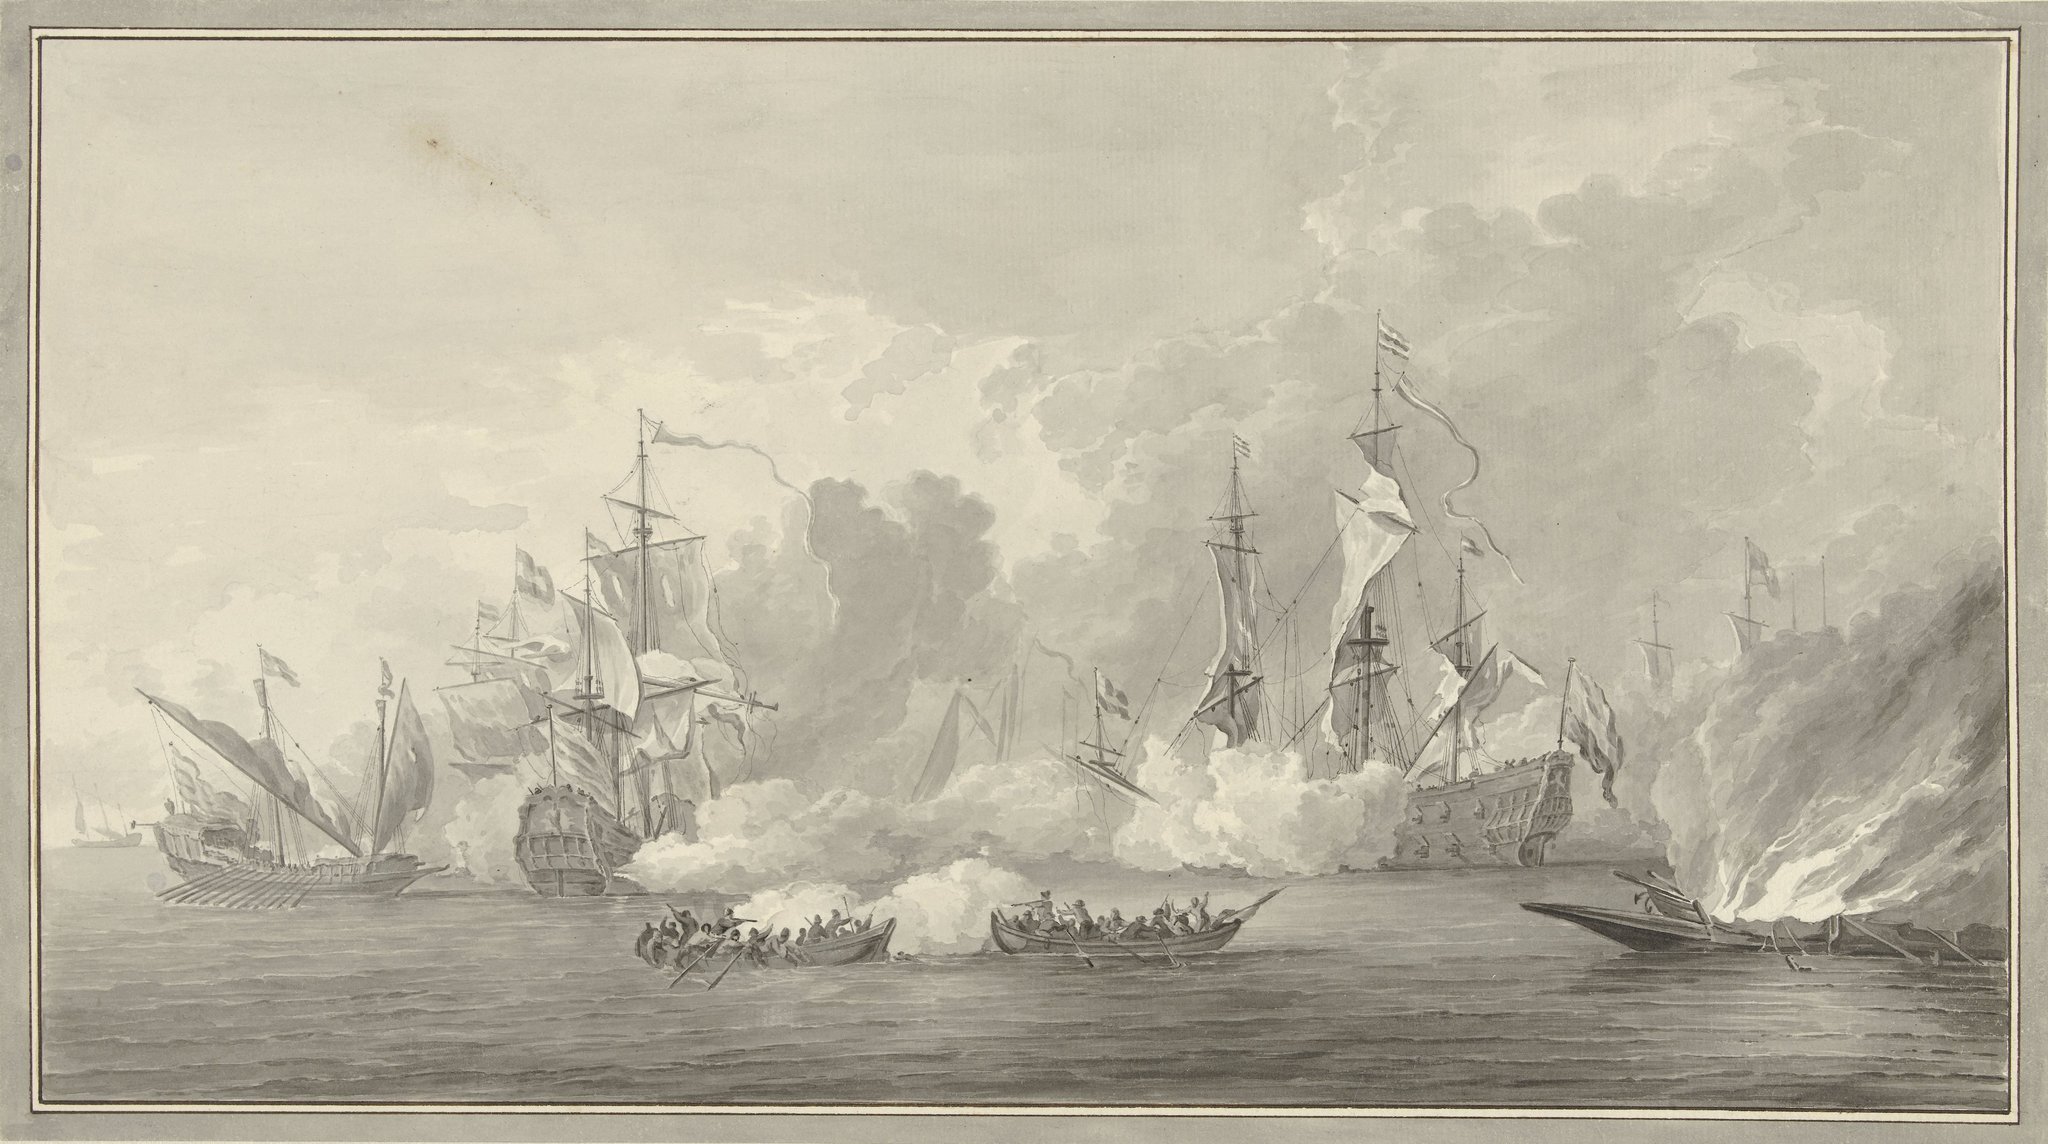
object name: drawing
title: Zeeslag, mogelijk bij Kijkduin op 21 augustus 1673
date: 1781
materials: ink, paper, pencil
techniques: brush, pen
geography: northern netherlands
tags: battle (+ naval force), battle of the texel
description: Voorstelling van een zeeslag, mogelijk de zeeslag bij bij Kijkduin op 21 augustus 1673 tussen de Staatse vloot onder Michiel de Ruyter en Cornelis Tromp en de Engels-Franse vloot onder prins Rupert en graaf Jean d'Estrées (II). Links een grote galei met riemen.